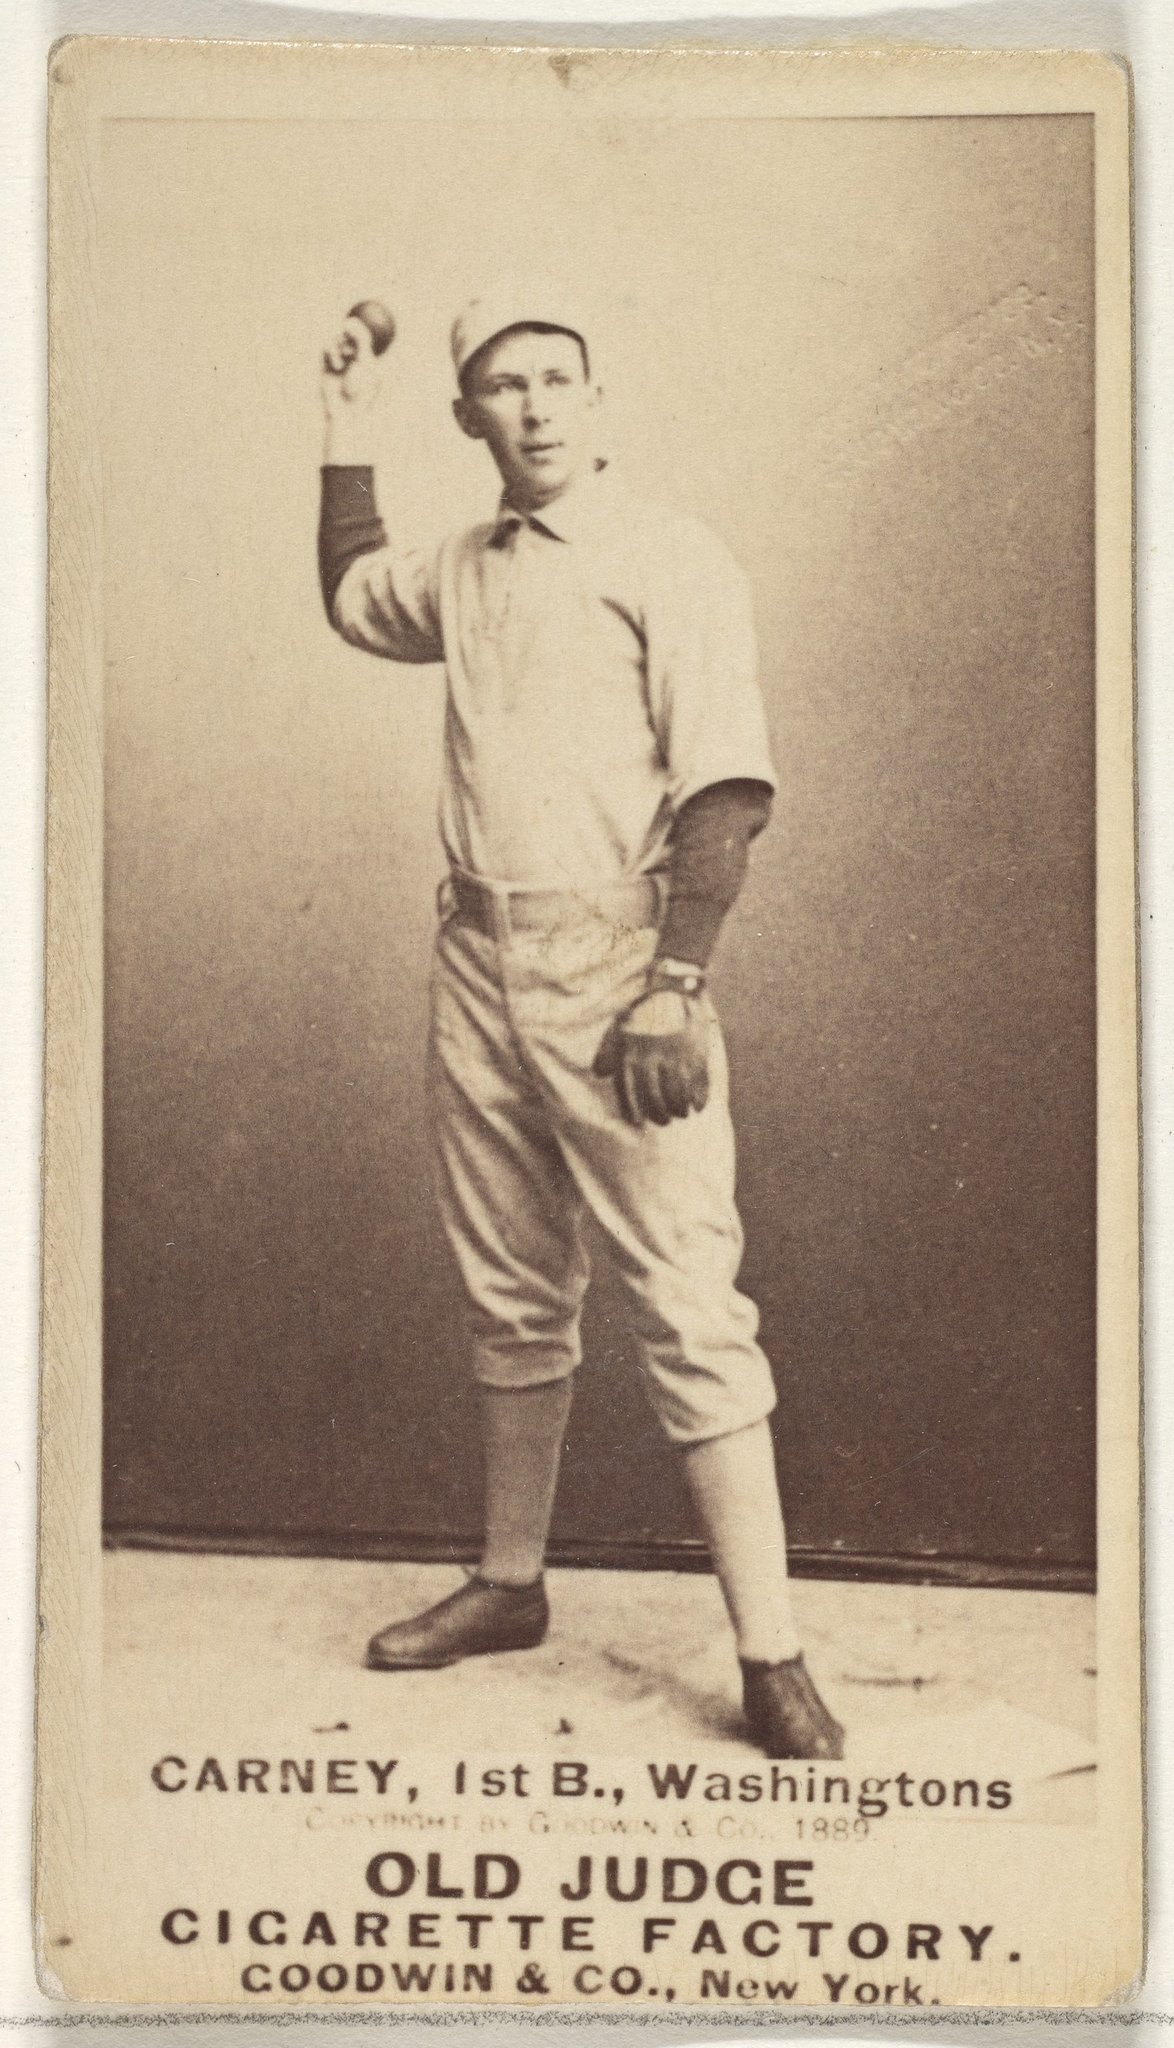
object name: baseball card, photograph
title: John Joseph "Handsome Jack" Carney, 1st Base, Washington Nationals, from the Old Judge series (N172) for Old Judge Cigarettes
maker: goodwin & company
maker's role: publisher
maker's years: 1850-1950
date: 1889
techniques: albumen silver print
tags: men,portraits,baseball,athletes